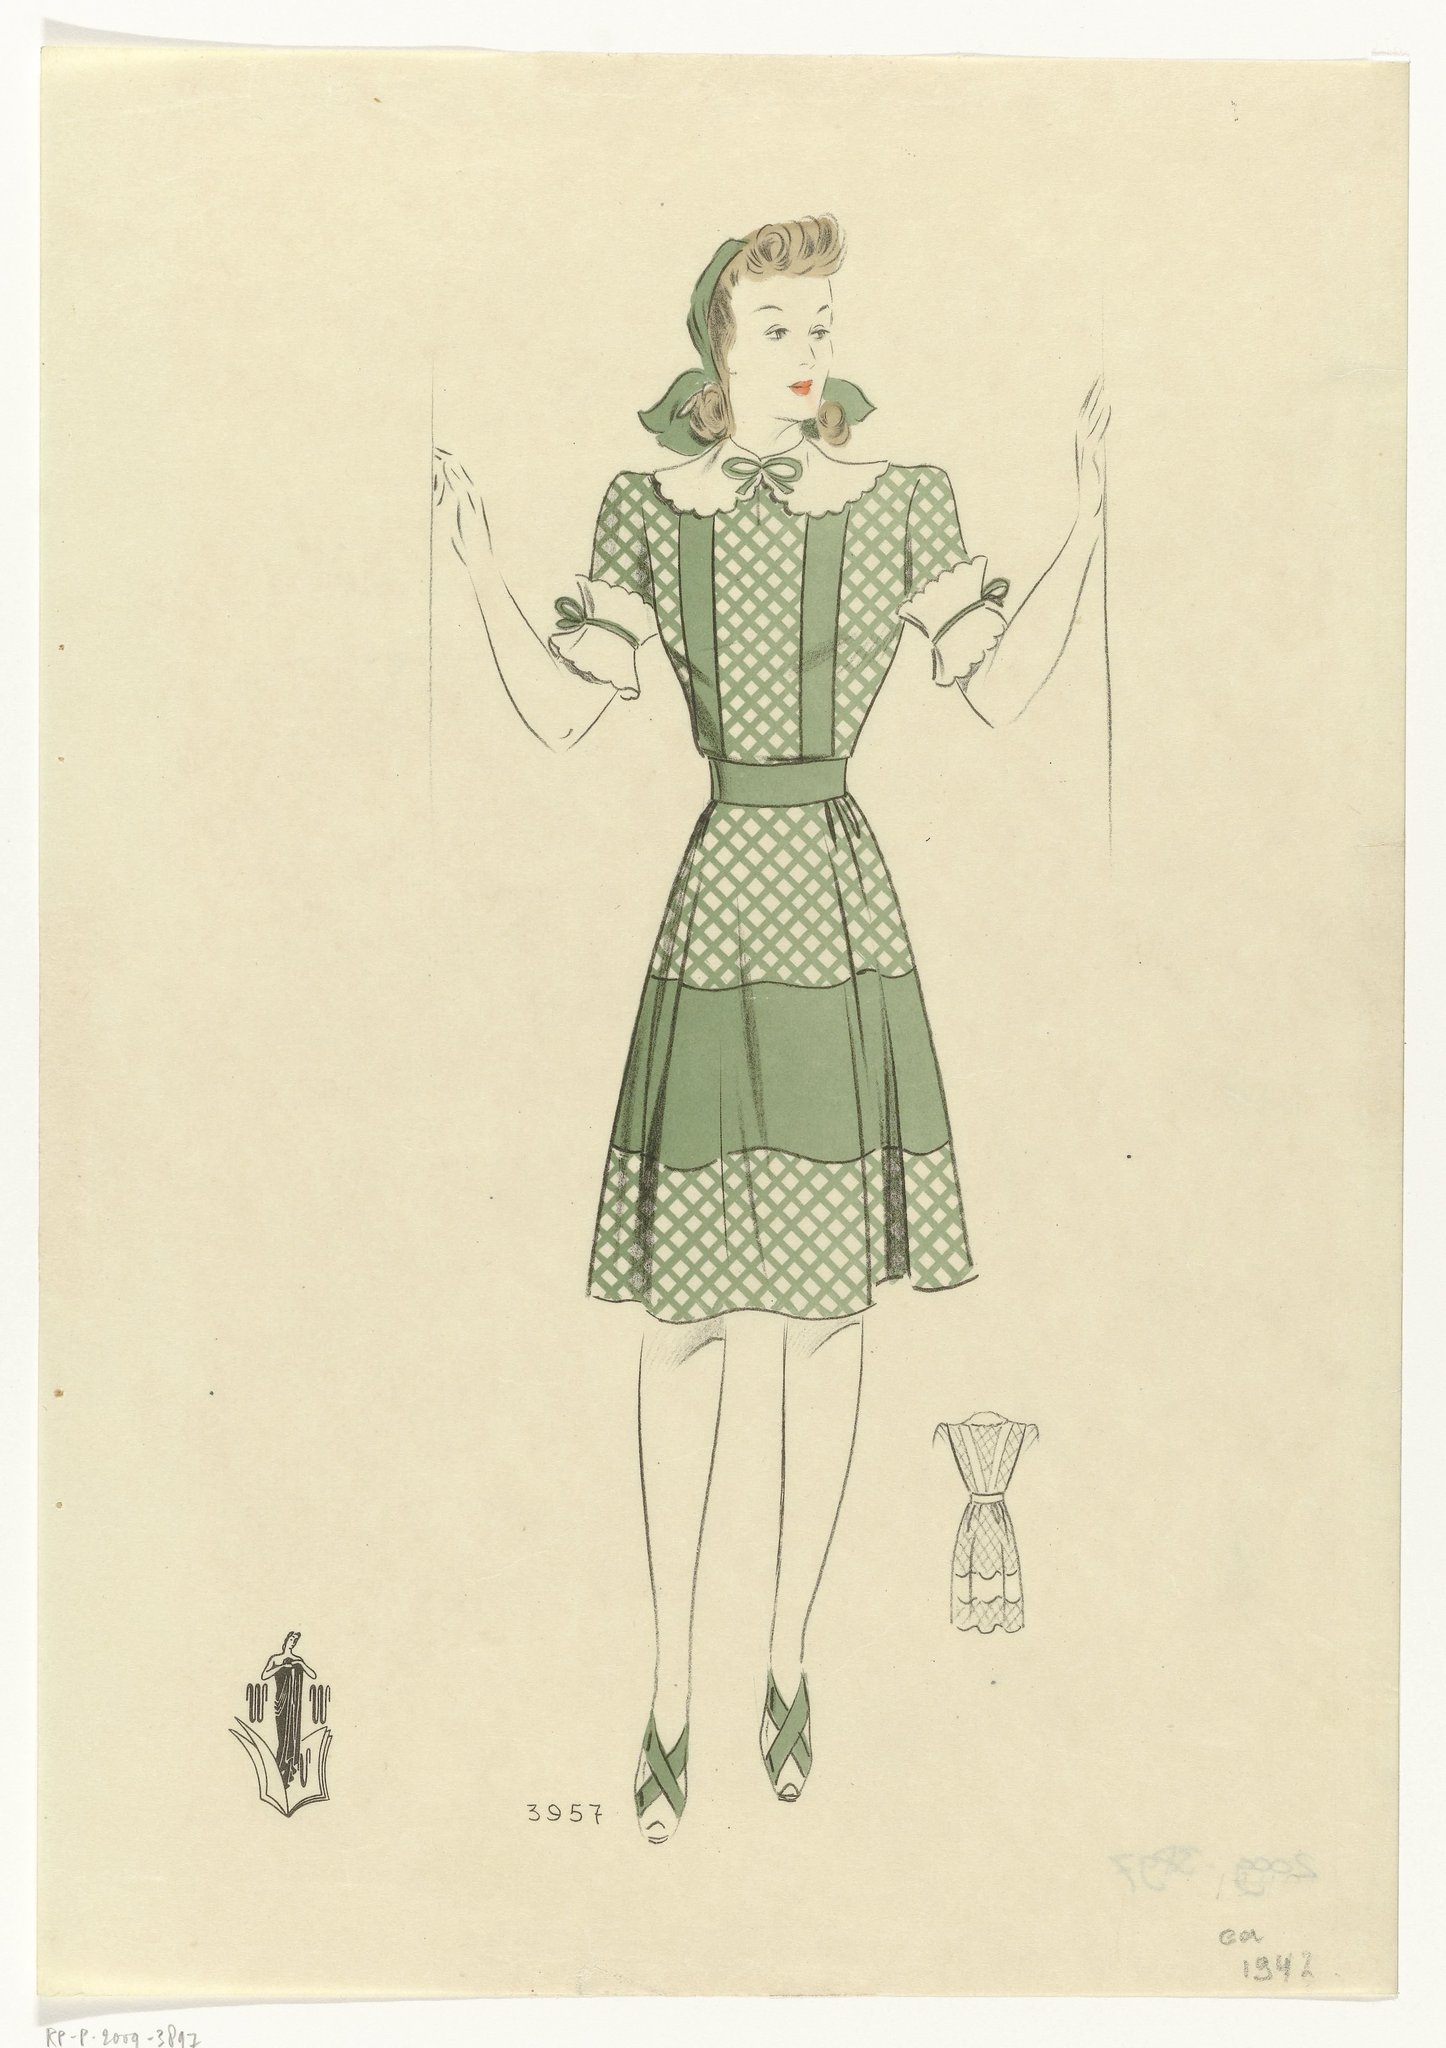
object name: fashion print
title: Vrouw met groene jurk, ca. 1942, No. 3957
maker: Anonymous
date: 1942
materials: paper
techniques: hand coloring, lithograph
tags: head-gear (headscarf) (+ women's clothes), fashion plates, shoes, sandals (+ women's clothes), dress, gown (+ women's clothes)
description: Jonge vrouw in groen geruite jurk tot op de knie, korte mouwen tot de elleboog. Wit kraagje en witte manchetten. Schoenen met hoge hakken en kruisbanden over de wreef.